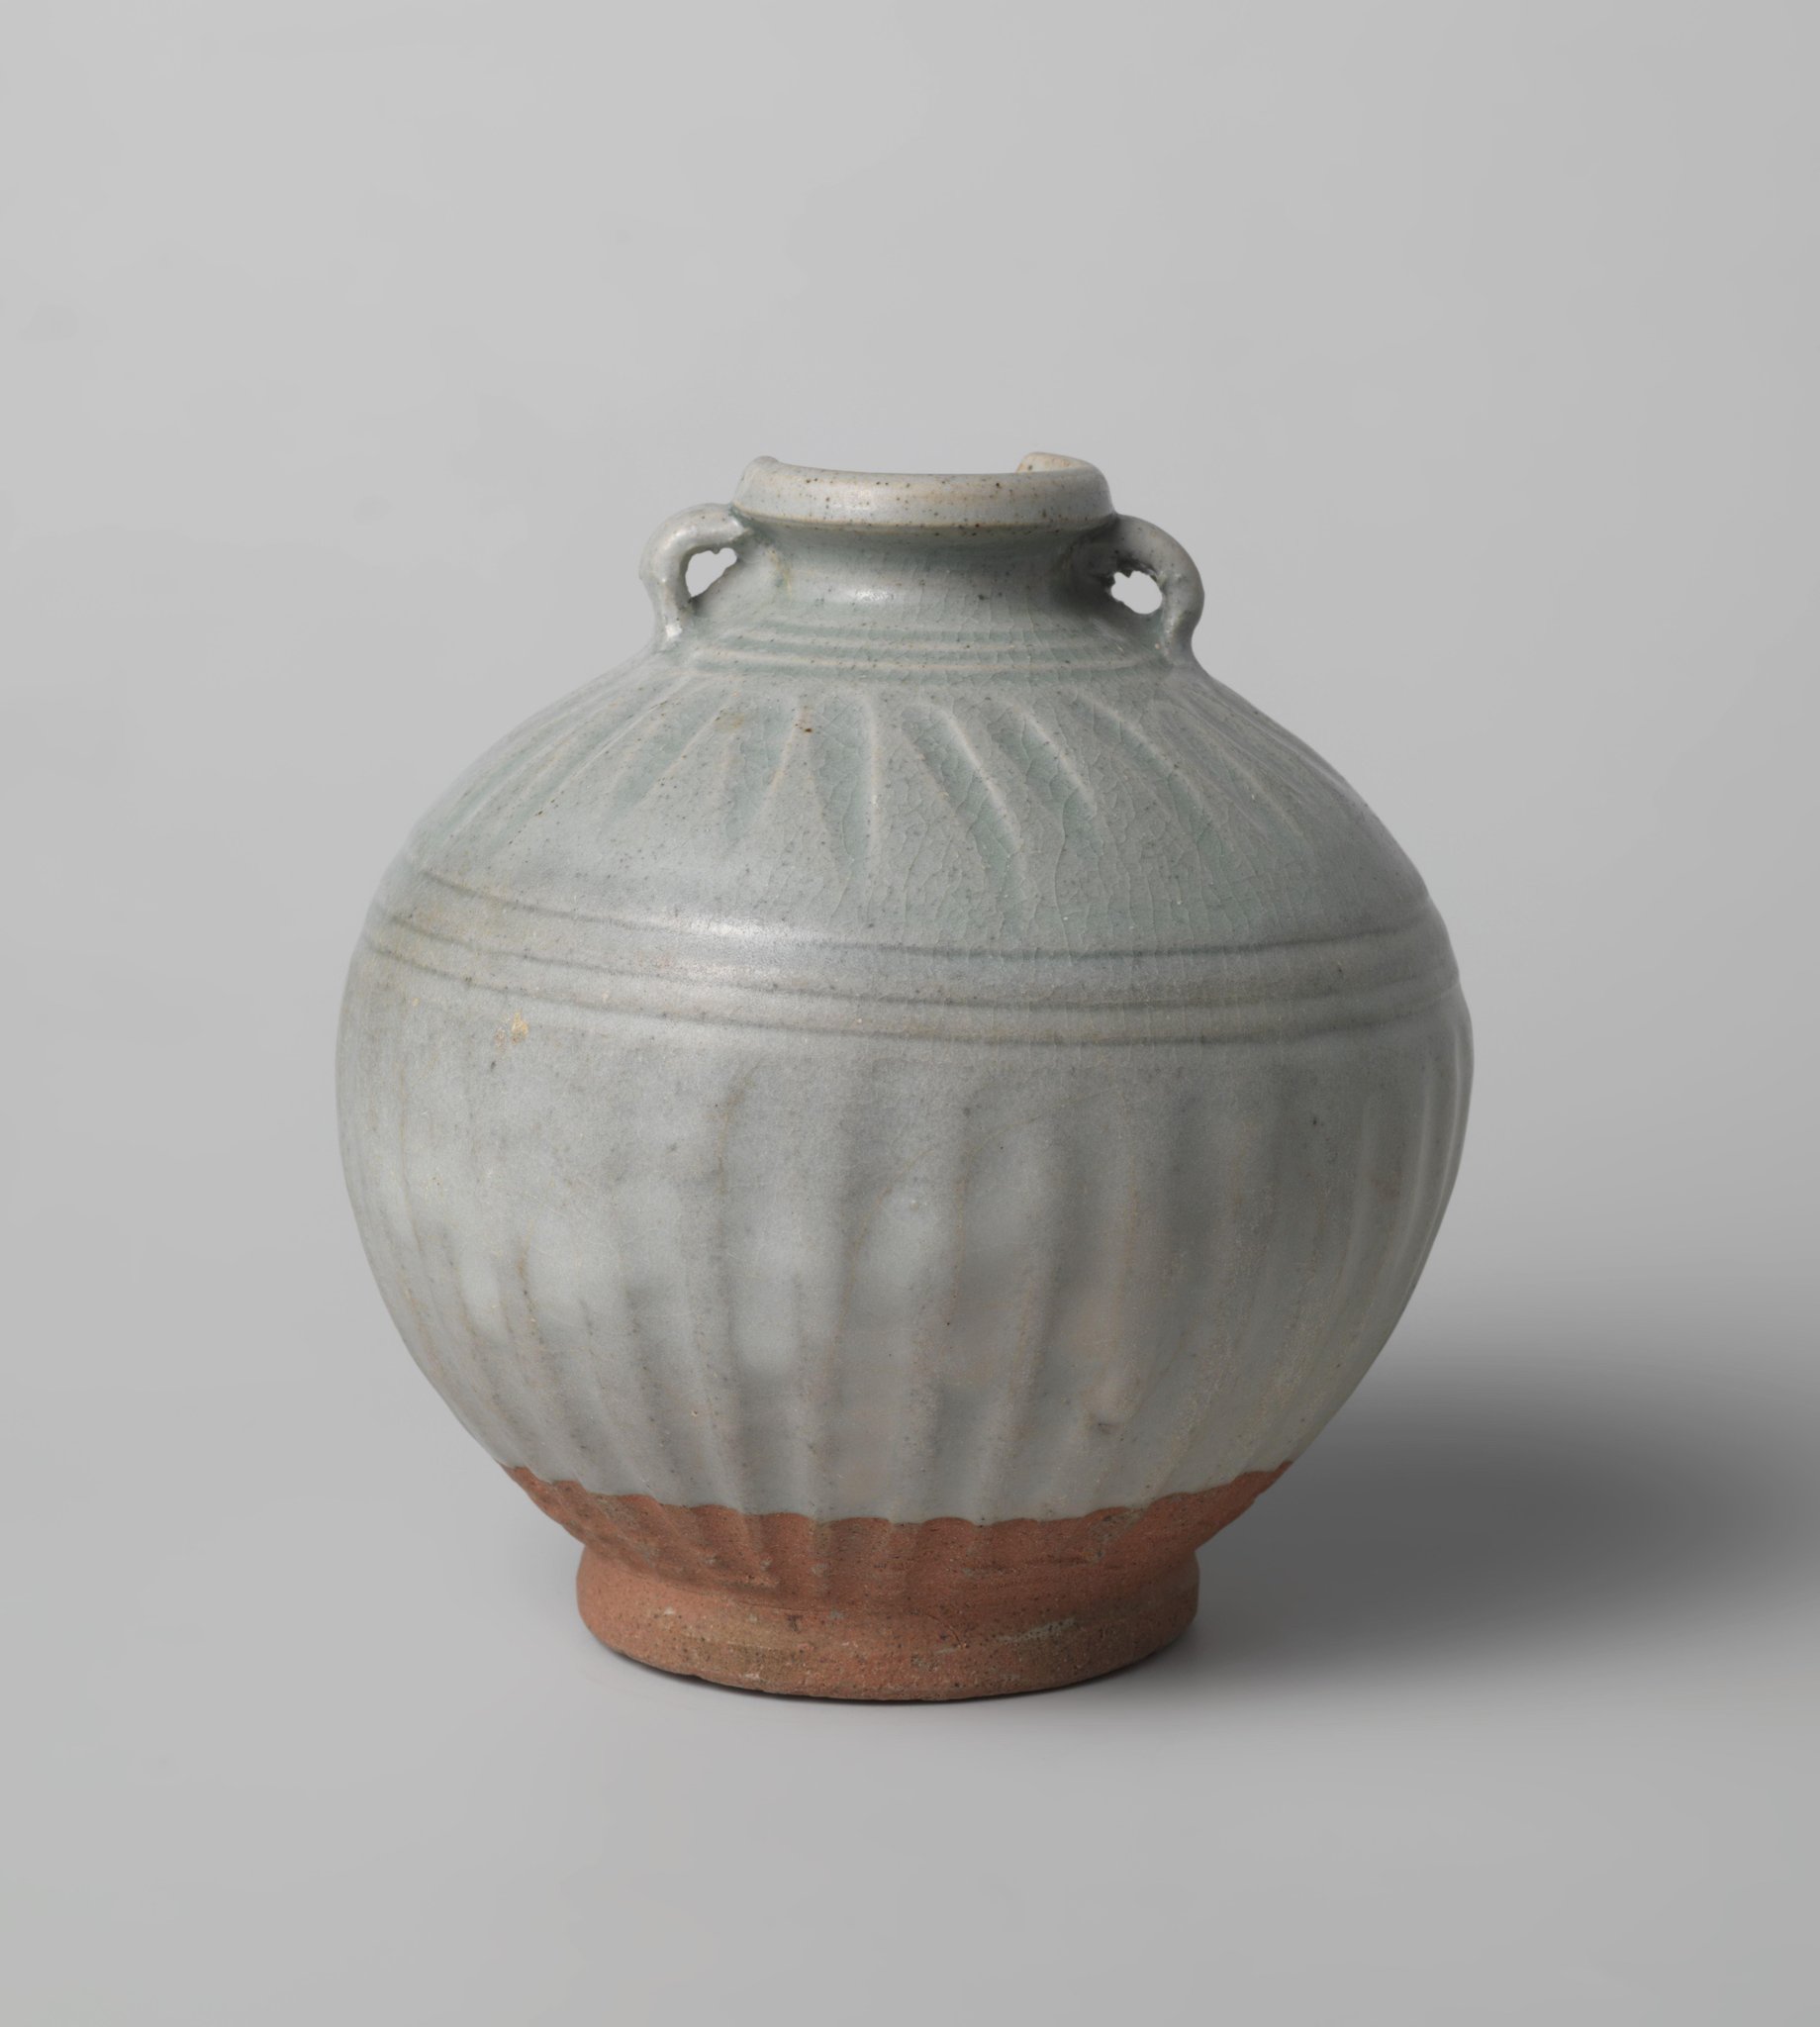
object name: pot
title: Round-bodied jar with fluted sides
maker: Anonymous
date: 1300-1499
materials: ceramic glaze, stoneware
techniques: engraving, firing, turning, vitrification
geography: sawankhalok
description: Bolvormige pot van steengoed met een smalle, korte nek en opstaande rand, bedekt met een groen glazuur. Op de schouder, buik en rond de voet drie horizontale, ingegrifte lijnen. Daartussen is de wand geribd. Vanuit de schouder twee halfronde oren bevestigd aan de nek. Een scherf uit de rand, met resten van een restauratie. Celadon.